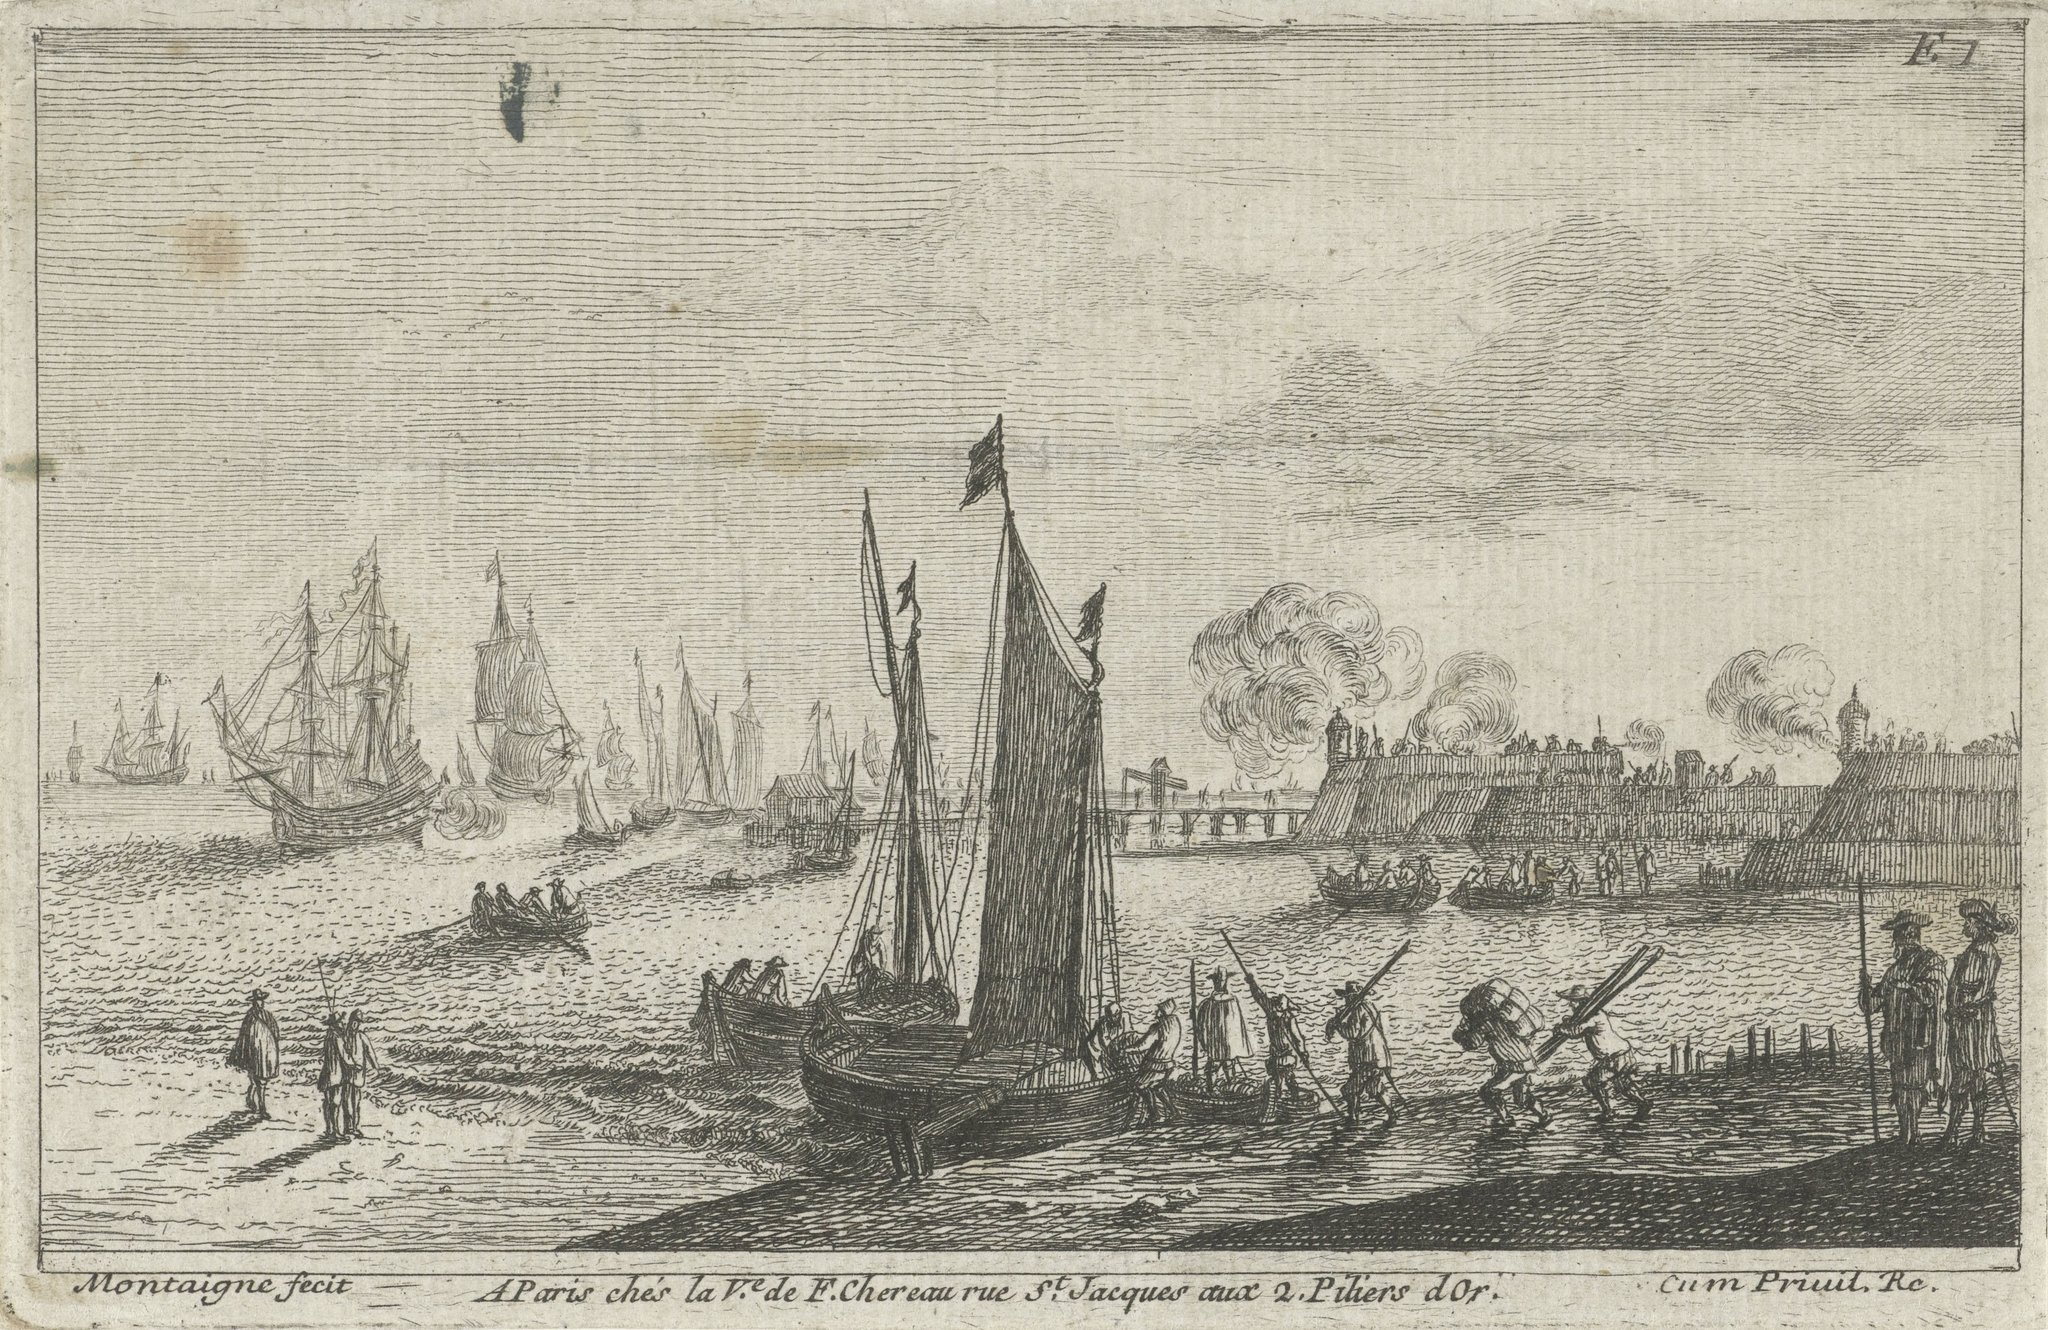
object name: print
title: Het laden van een schip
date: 1617-1660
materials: paper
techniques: etching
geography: paris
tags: fortress, harbouring (+ loading)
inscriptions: collector's mark: Lugt 2228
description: Gezicht op een haven met een vesting. Op de voorgrond het laden van een schip. Rechtsboven gemerkt: F.1.